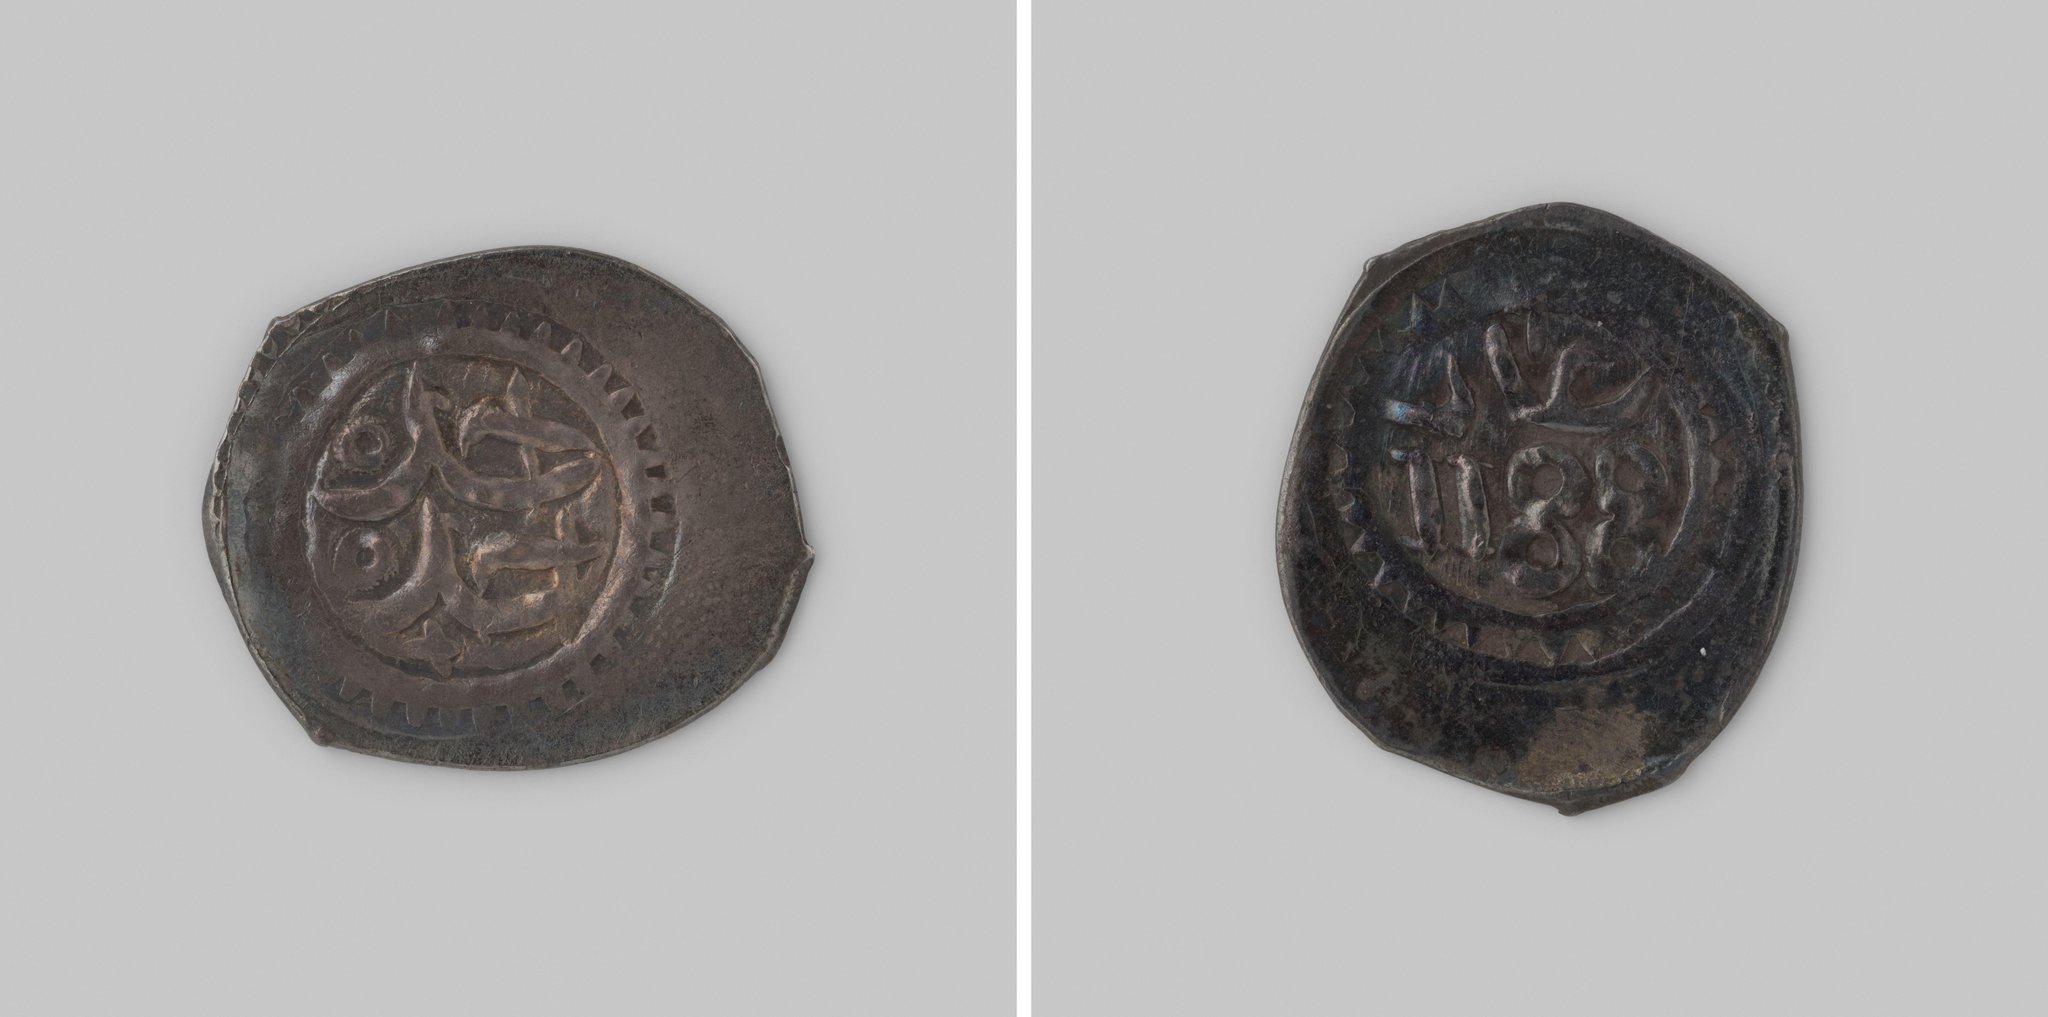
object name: coin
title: Dirhem uit Marokko van Mohammed III, 1188 [=1774]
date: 1774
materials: silver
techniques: striking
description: Zilveren munt op hoekig muntplaatje. Voorzijde: tweeregelig opschrift in Arabische letters. Keerzijde: eenregelig opschrift in Arabische letters, waaronder jaartal in Westers-Arabische cijfers: 1188 [=1774].